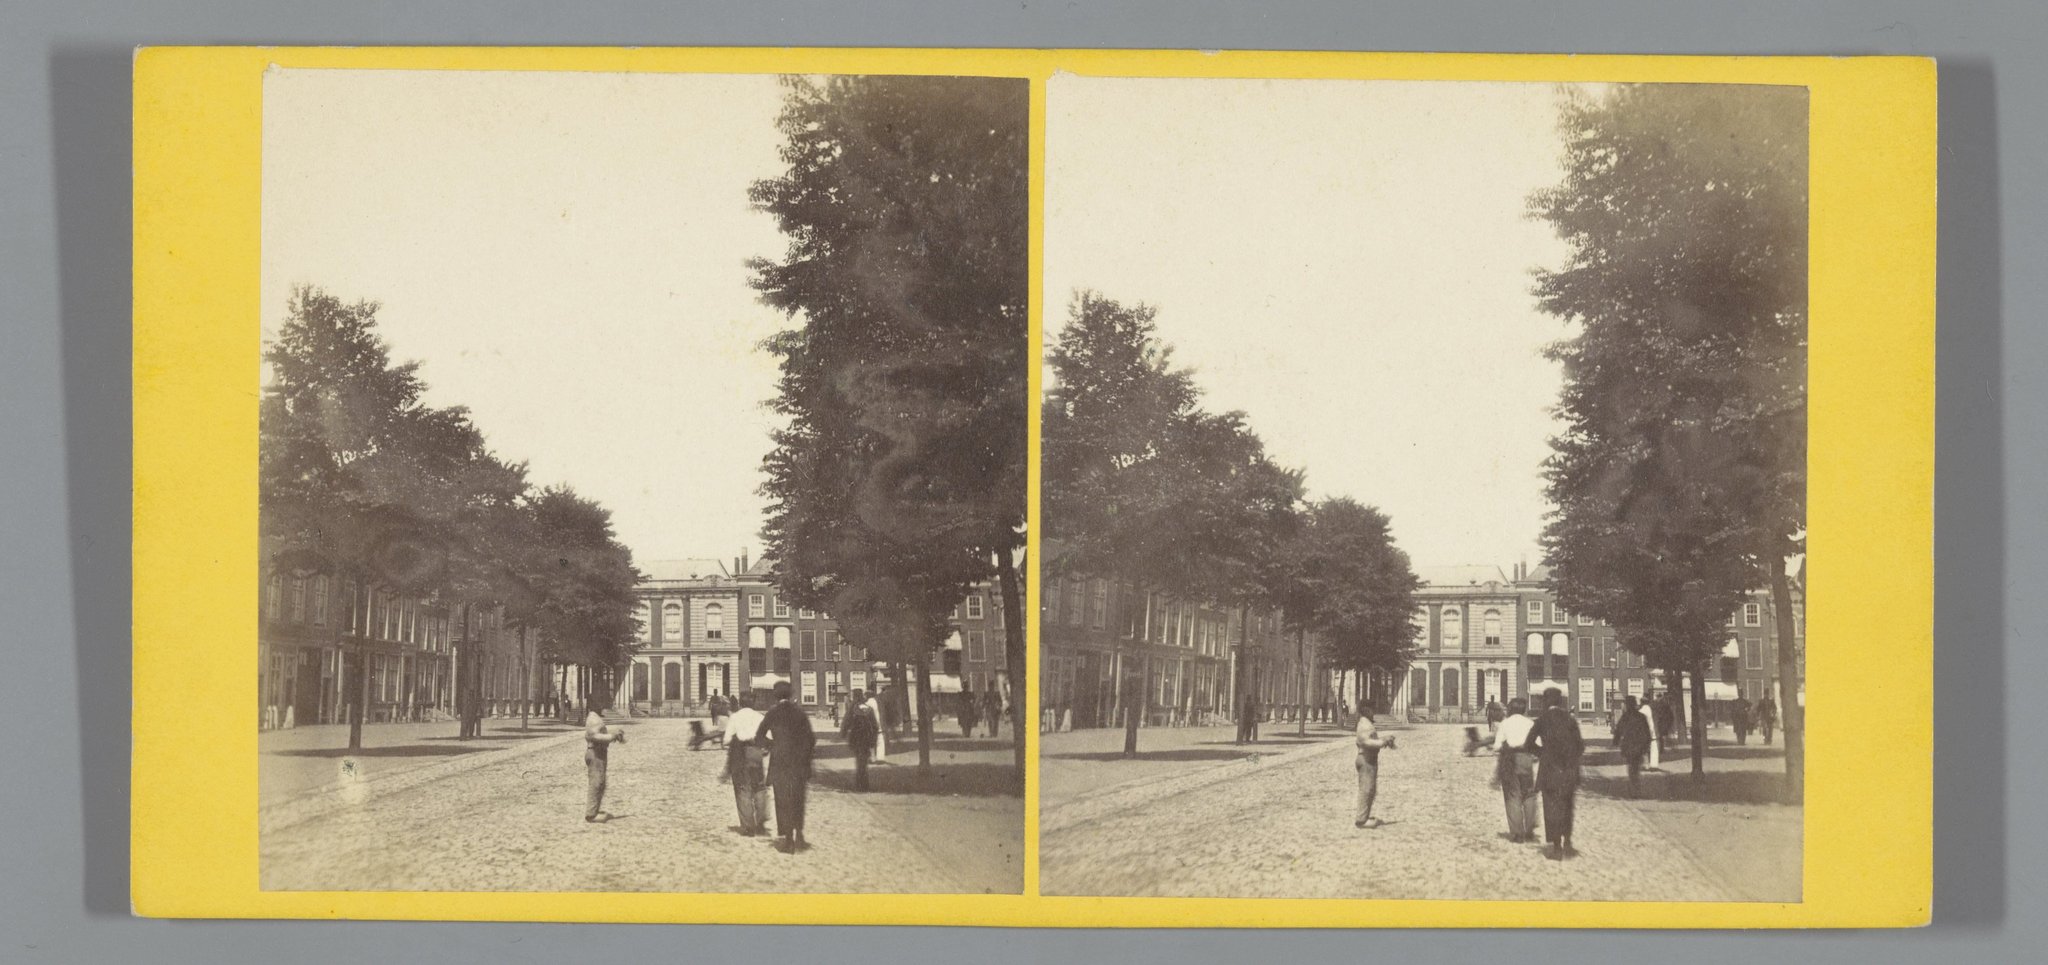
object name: stereograph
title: Gezicht op de Kneuterdijk in Den Haag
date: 1860-1885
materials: cardboard, photographic support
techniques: albumen print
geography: amsterdam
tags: street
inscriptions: inscription: ‘No. 79. DE KNEUTERDIJK/ TE/ 's Gravenhage./ A. JAGER, WATER 110, TE AMSTERDAM.’